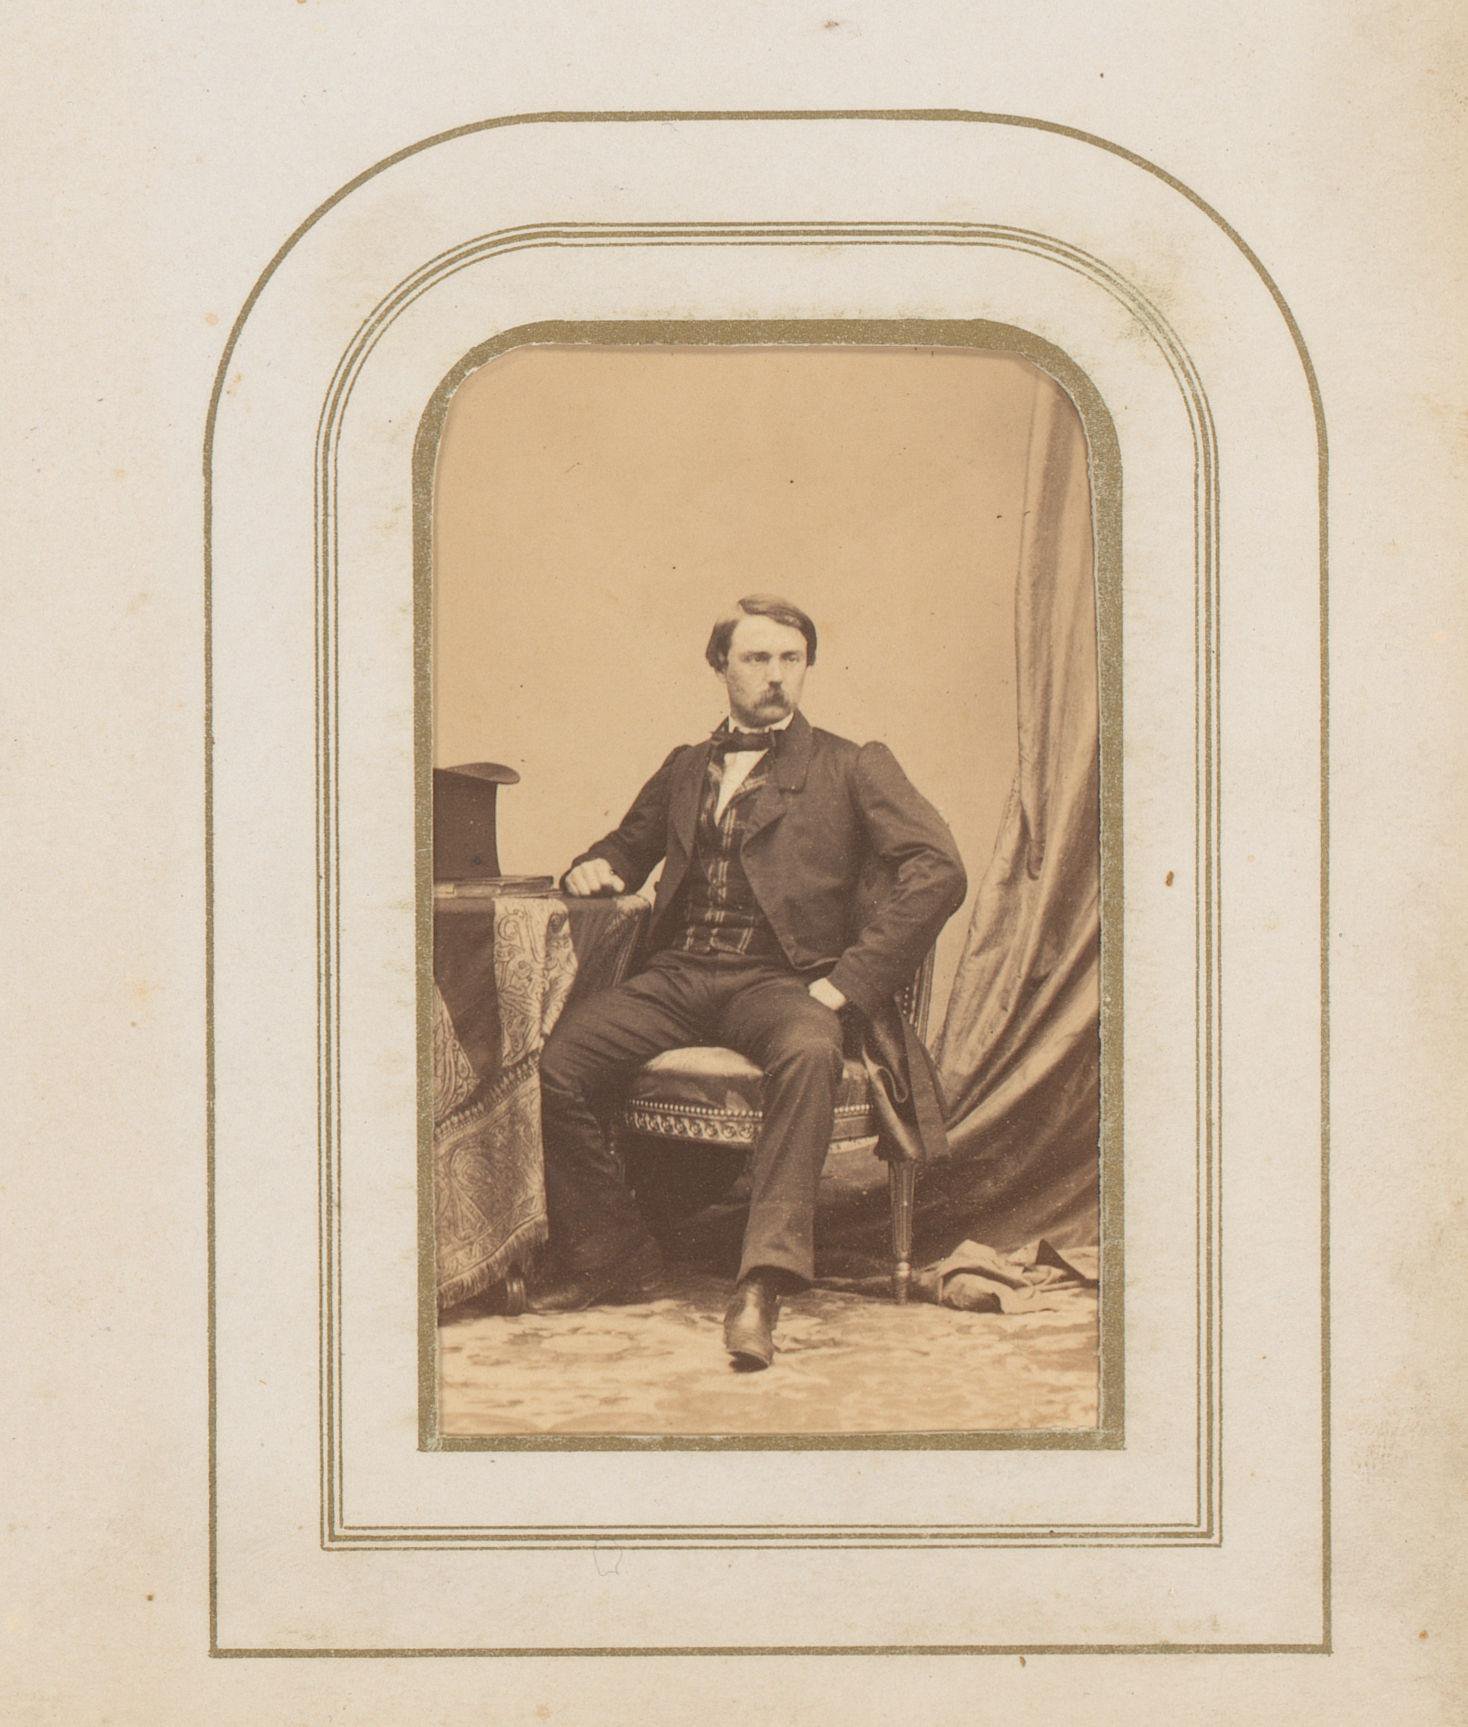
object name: album leaf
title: Portret van een meisje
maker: eugene guérin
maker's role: fotograaf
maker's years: 1845-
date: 1875-1885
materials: cardboard, photographic support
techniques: albumen print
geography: brussels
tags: historical persons - bb - woman, girl (child between toddler and youth)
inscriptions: inscription: ‘Eugene Guérin/ 142, Rue Royale, 142/ Bruxelles’